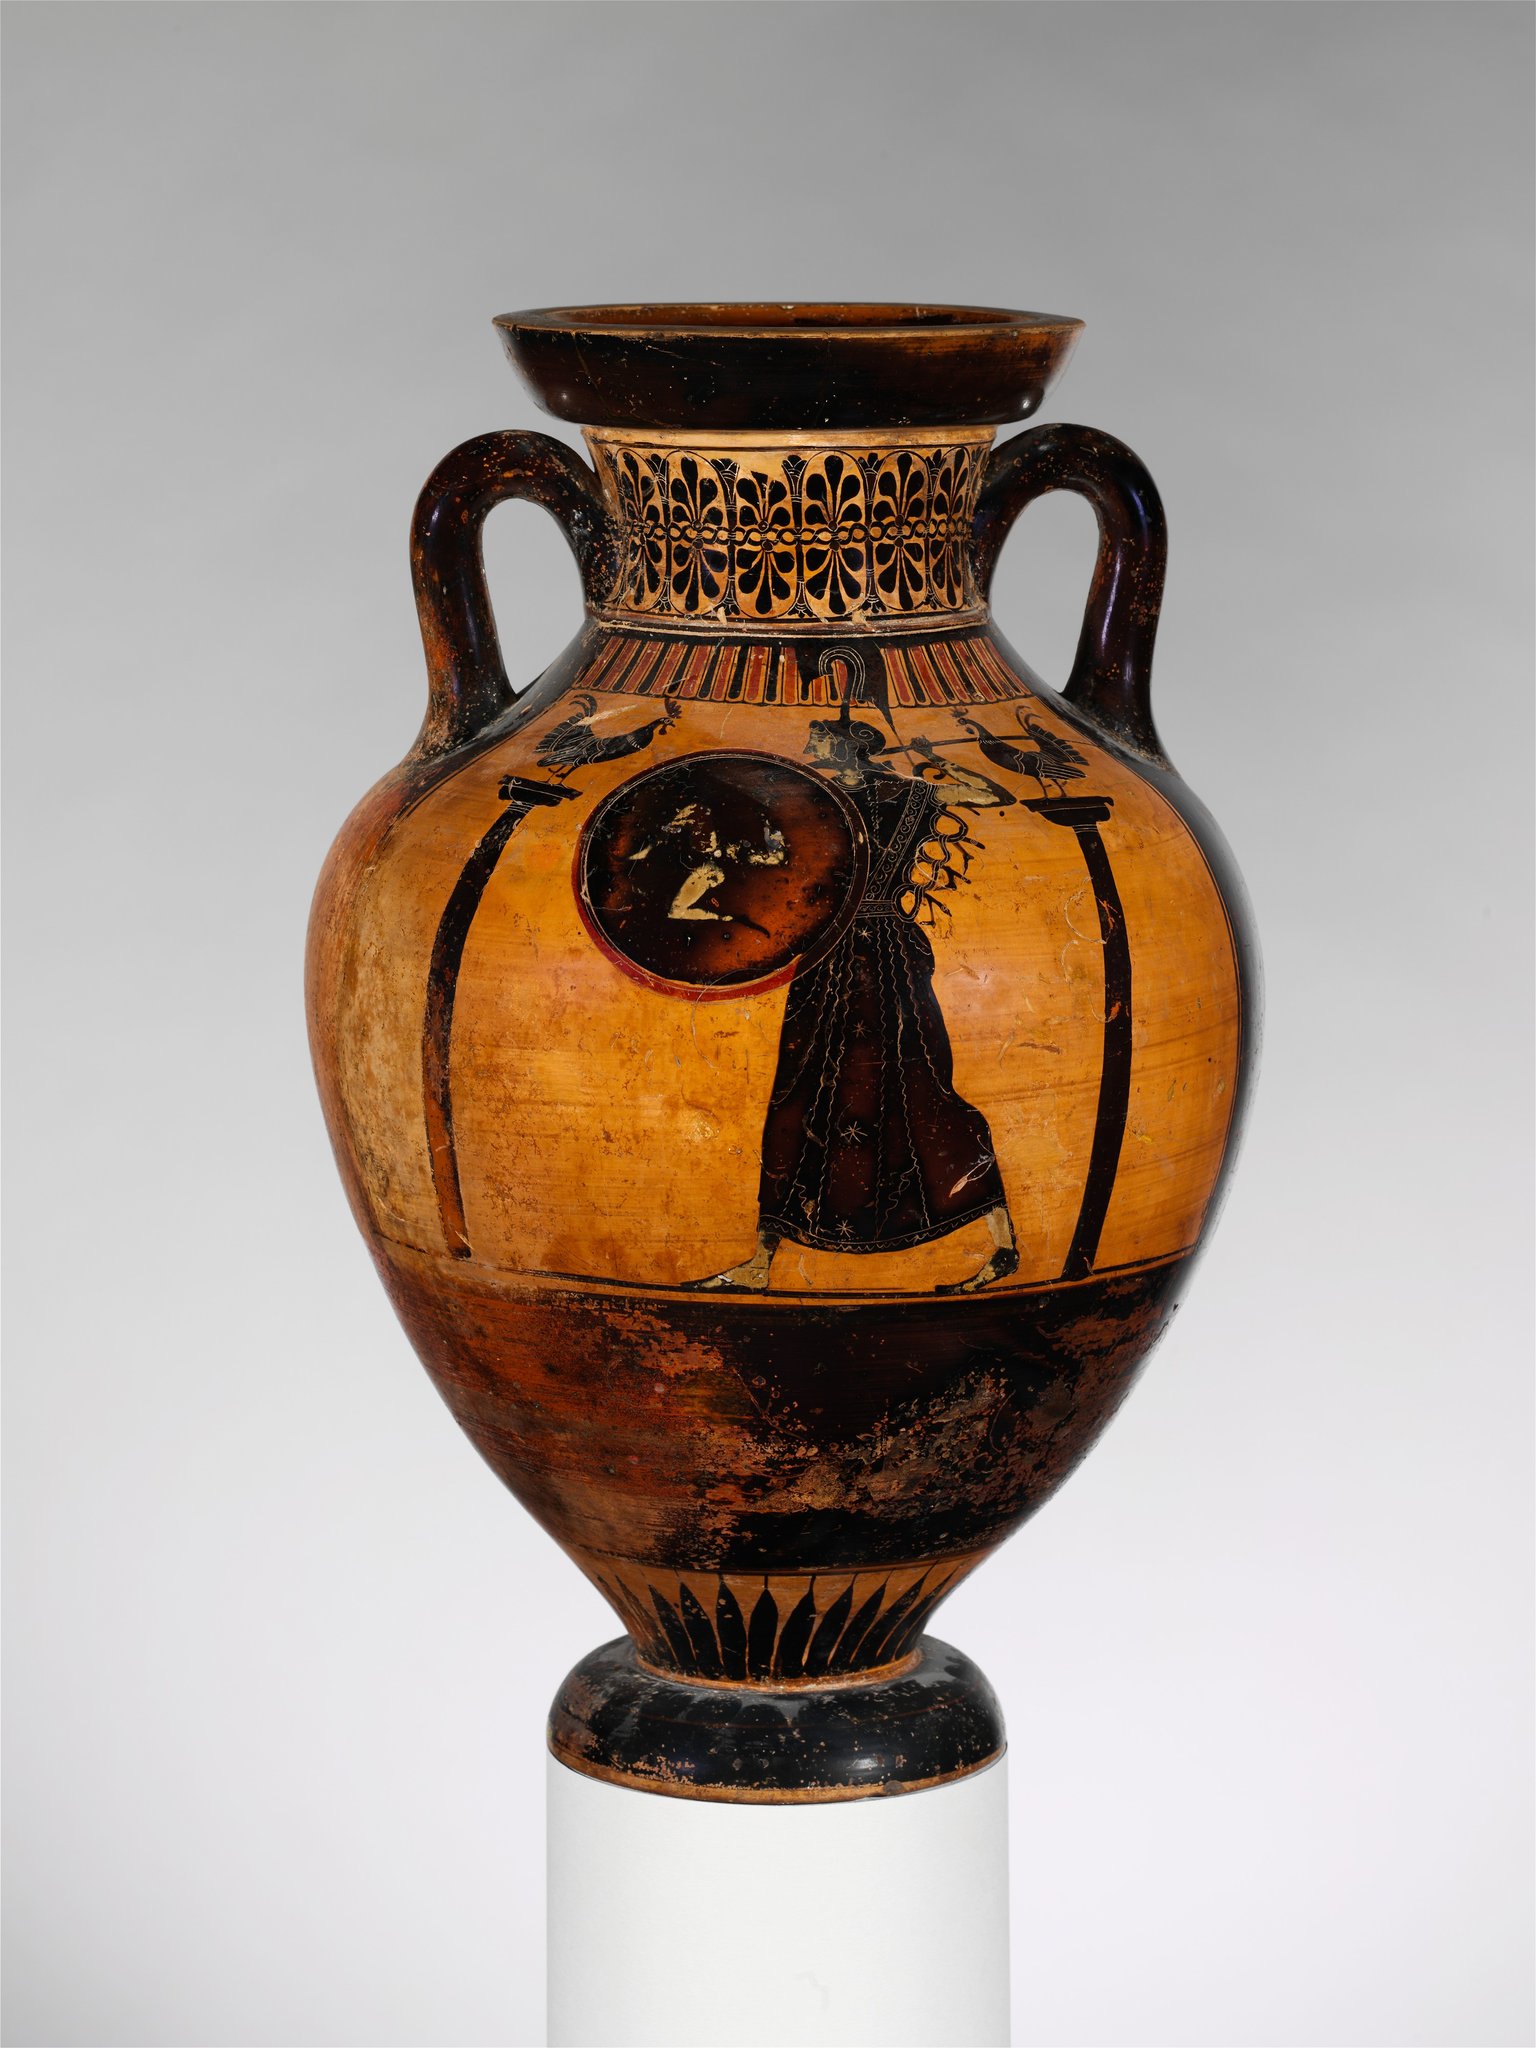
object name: neck amphora of panathenaic shape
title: Terracotta Panathenaic prize amphora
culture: greek, attic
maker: leagros group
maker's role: artist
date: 510 BCE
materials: terracotta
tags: shields,athena,horses,chariots